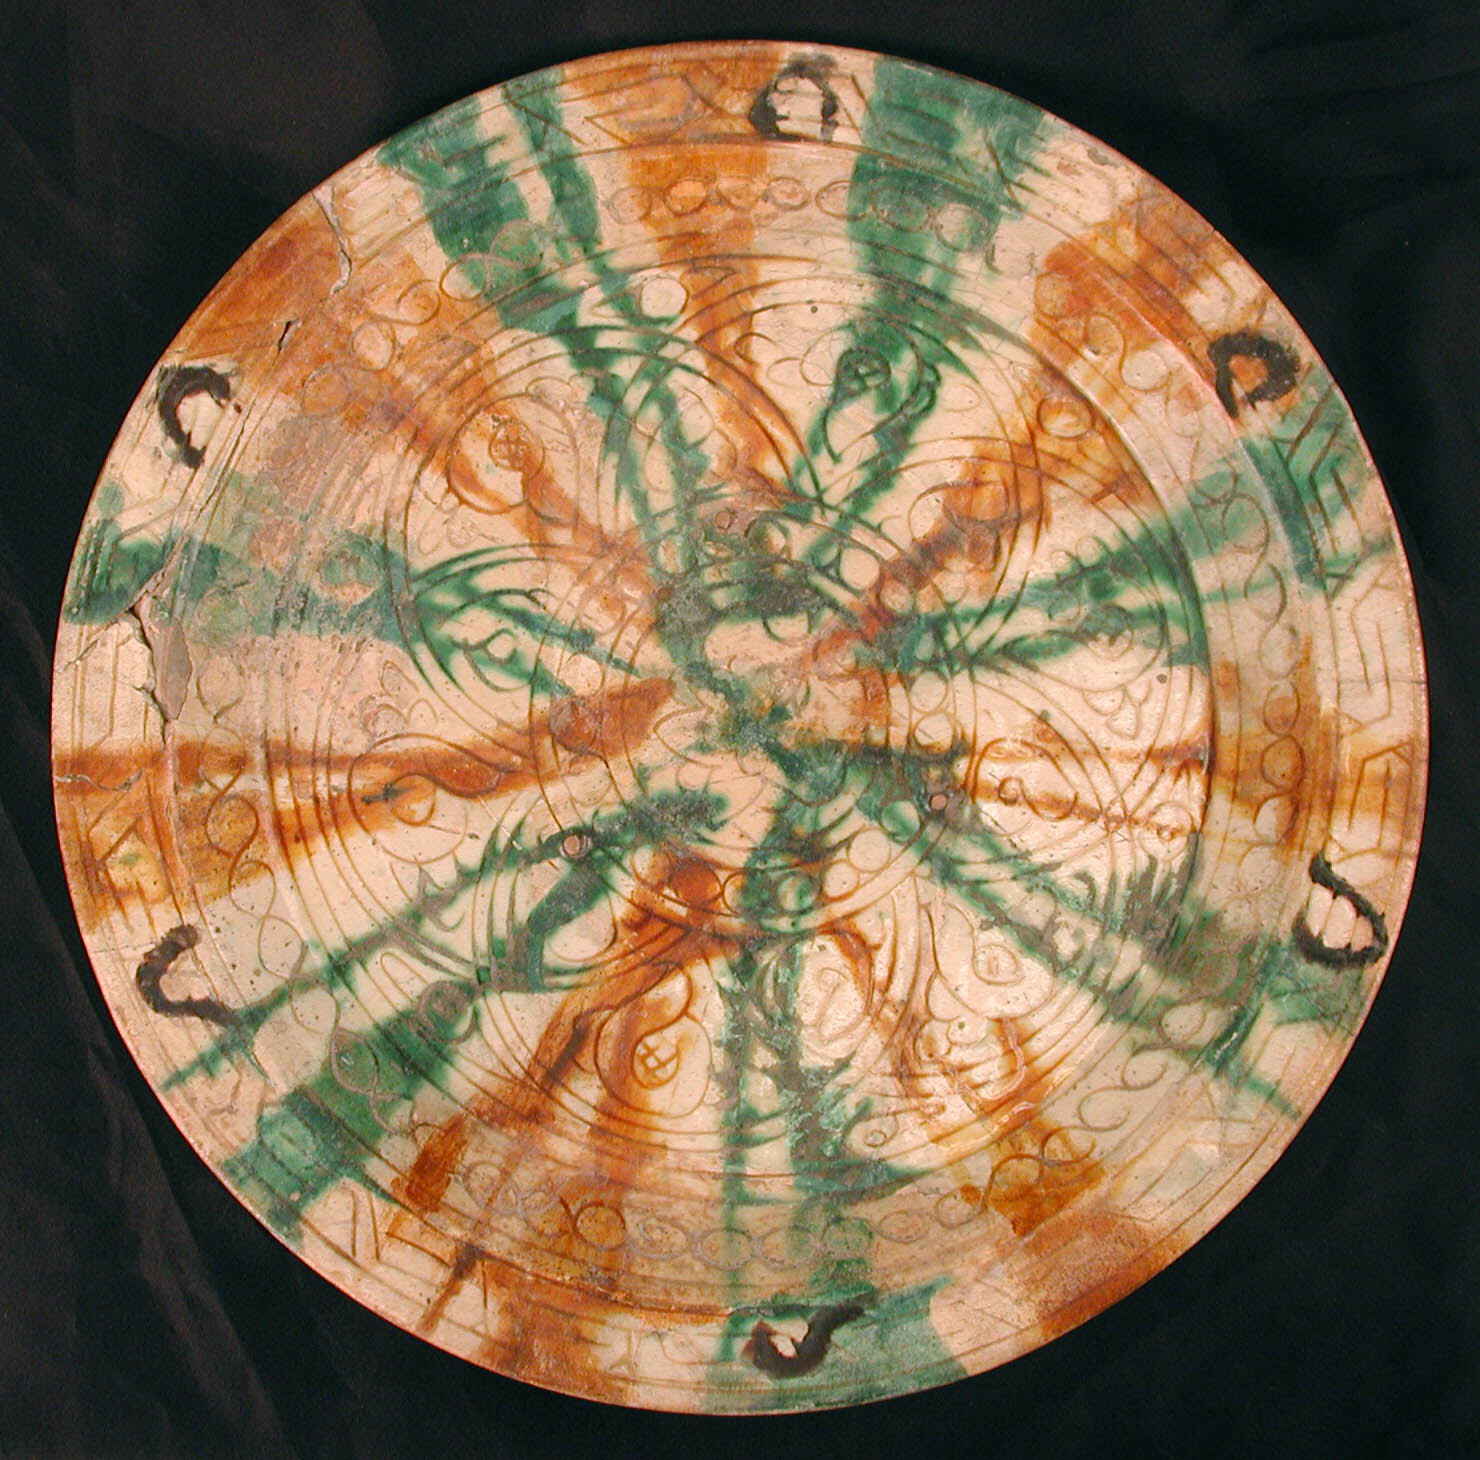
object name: plate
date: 801-1000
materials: earthenware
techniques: glazing, incising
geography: iran